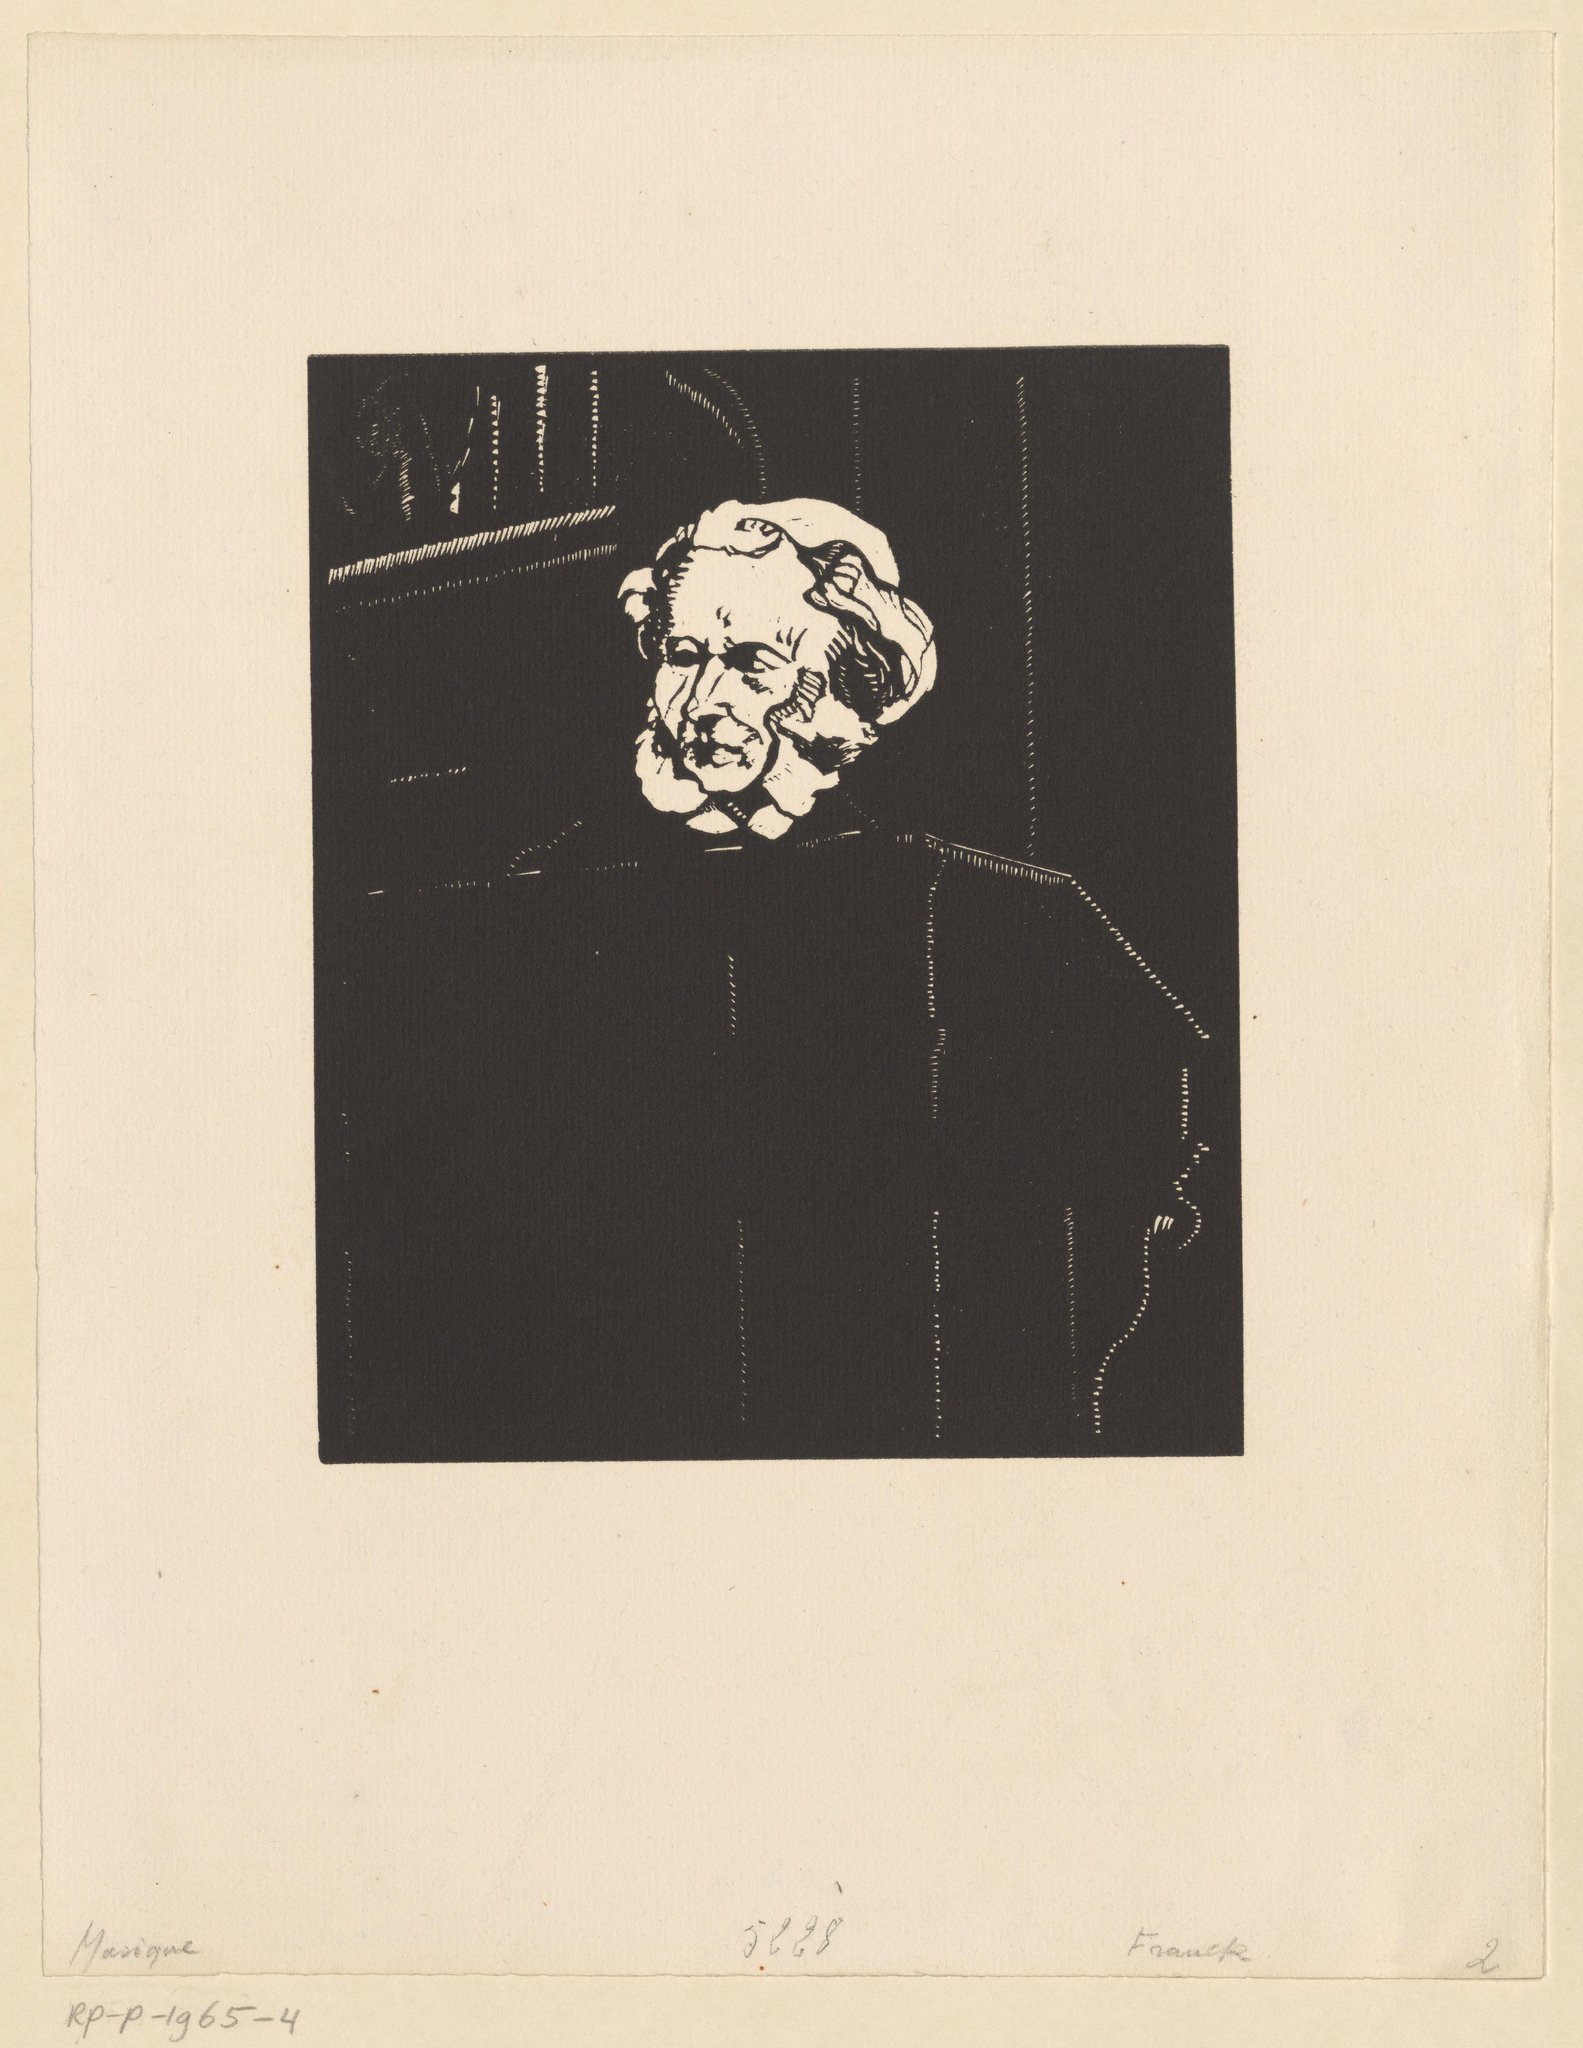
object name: print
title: Portret van César Franck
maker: Anonymous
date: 1870-1875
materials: paper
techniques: linocut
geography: netherlands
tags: liège, historical persons, portrait of composer